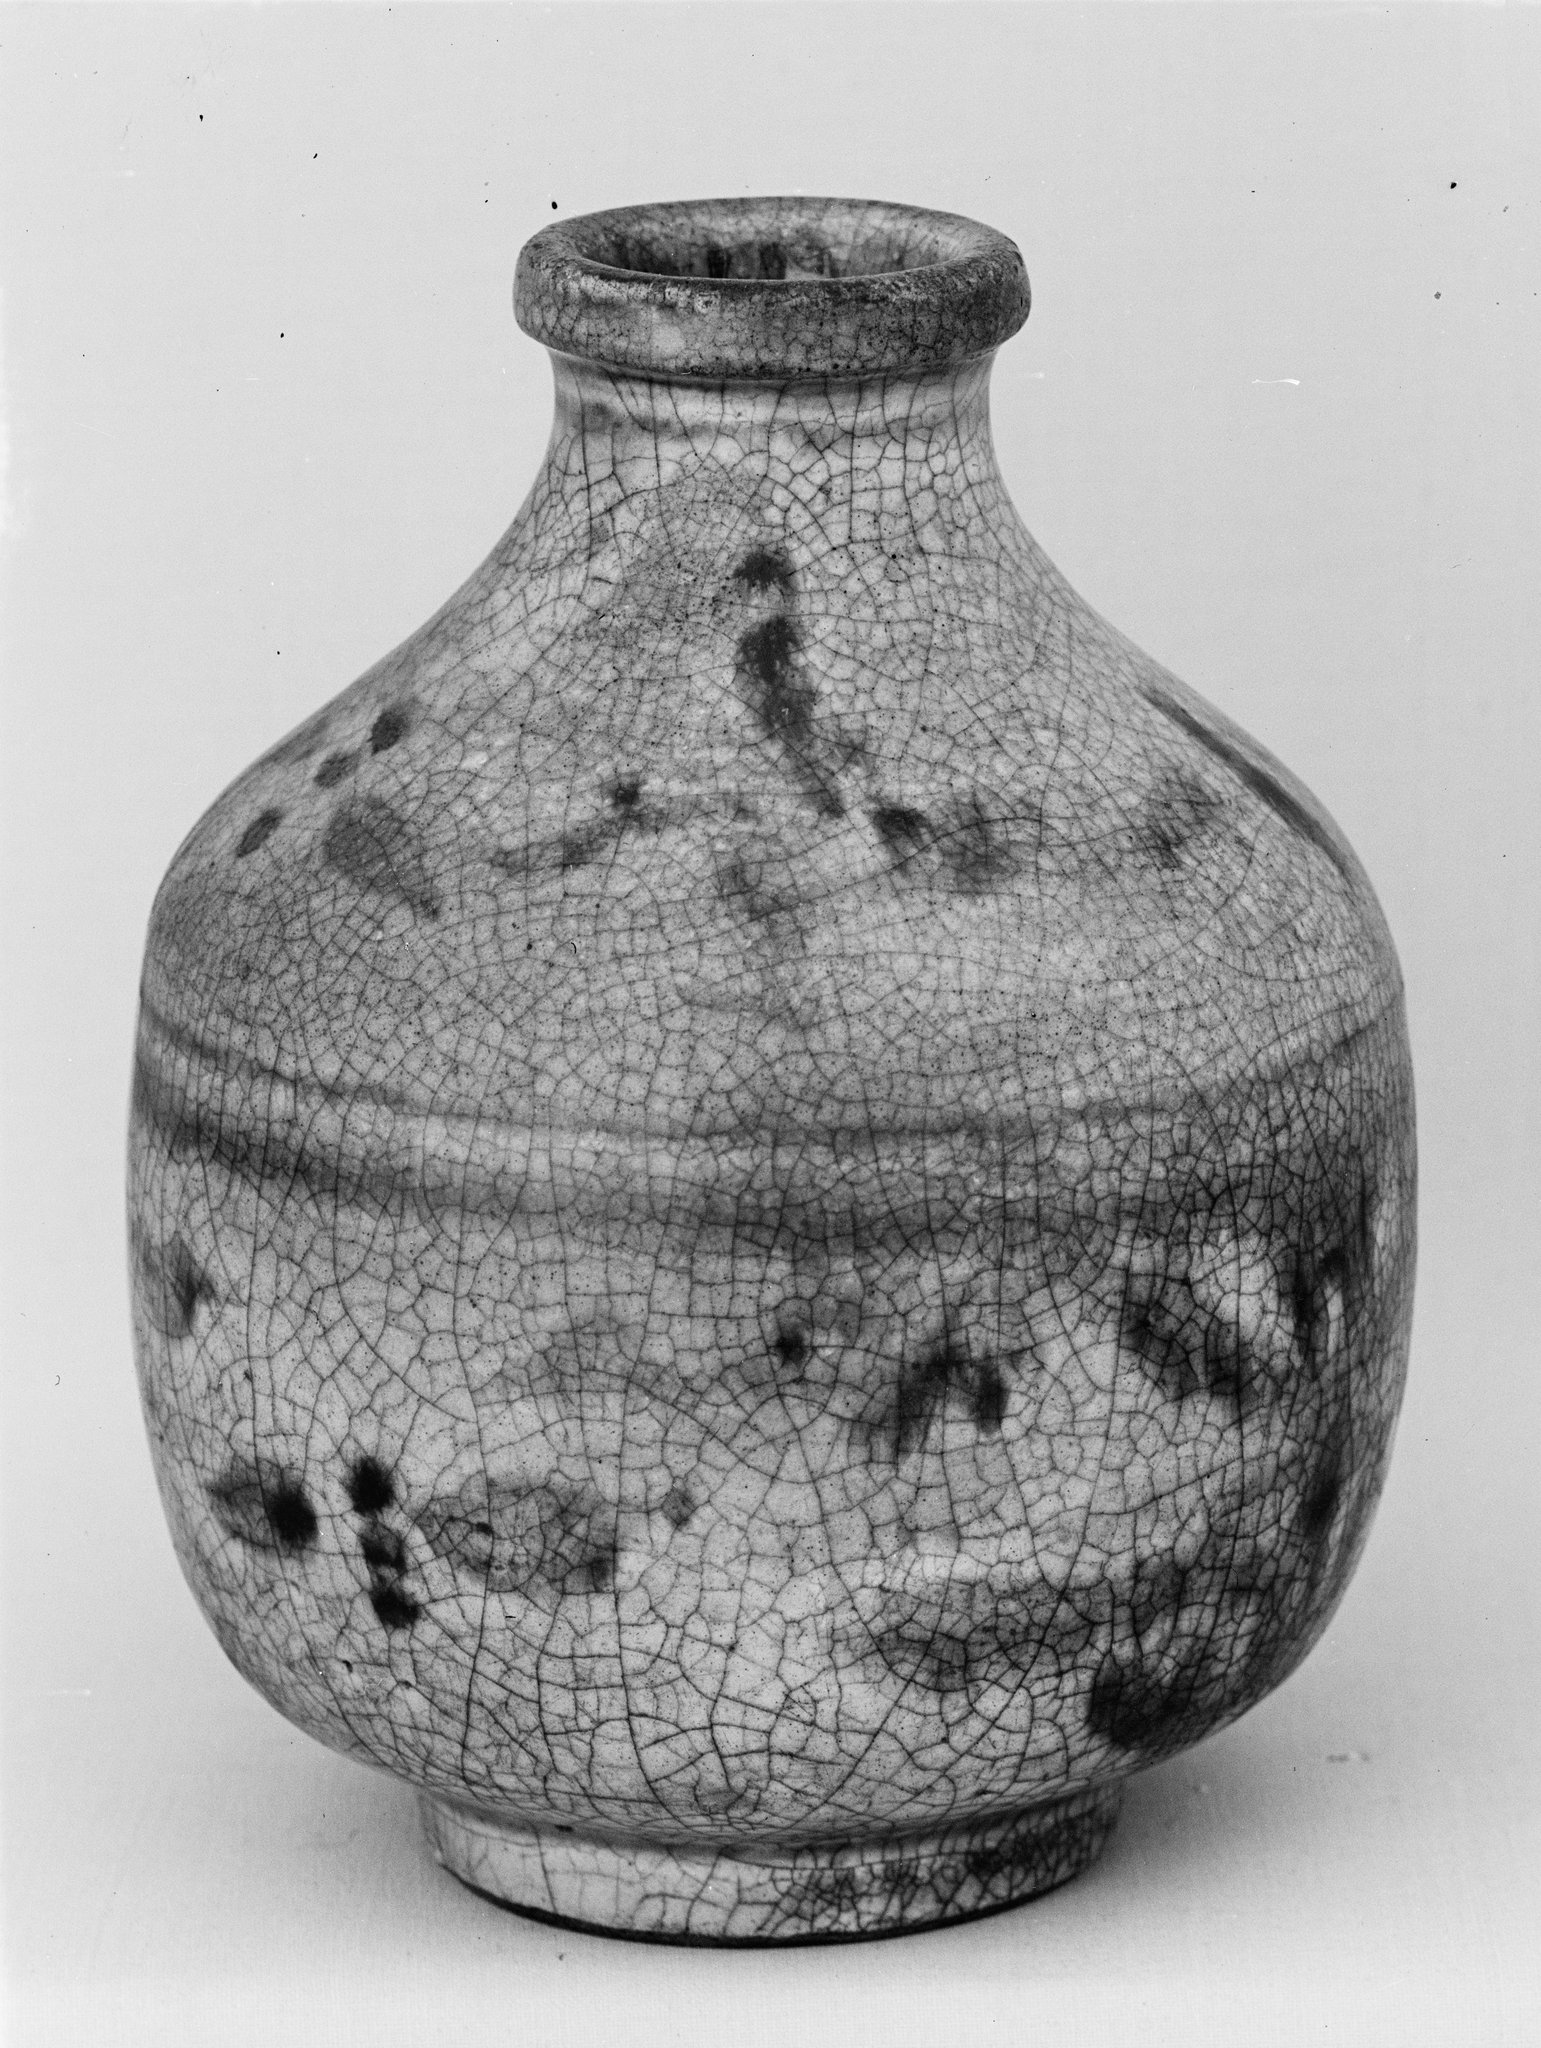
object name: bottle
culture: japanese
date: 1701-1800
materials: glaze, pottery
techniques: underglaze